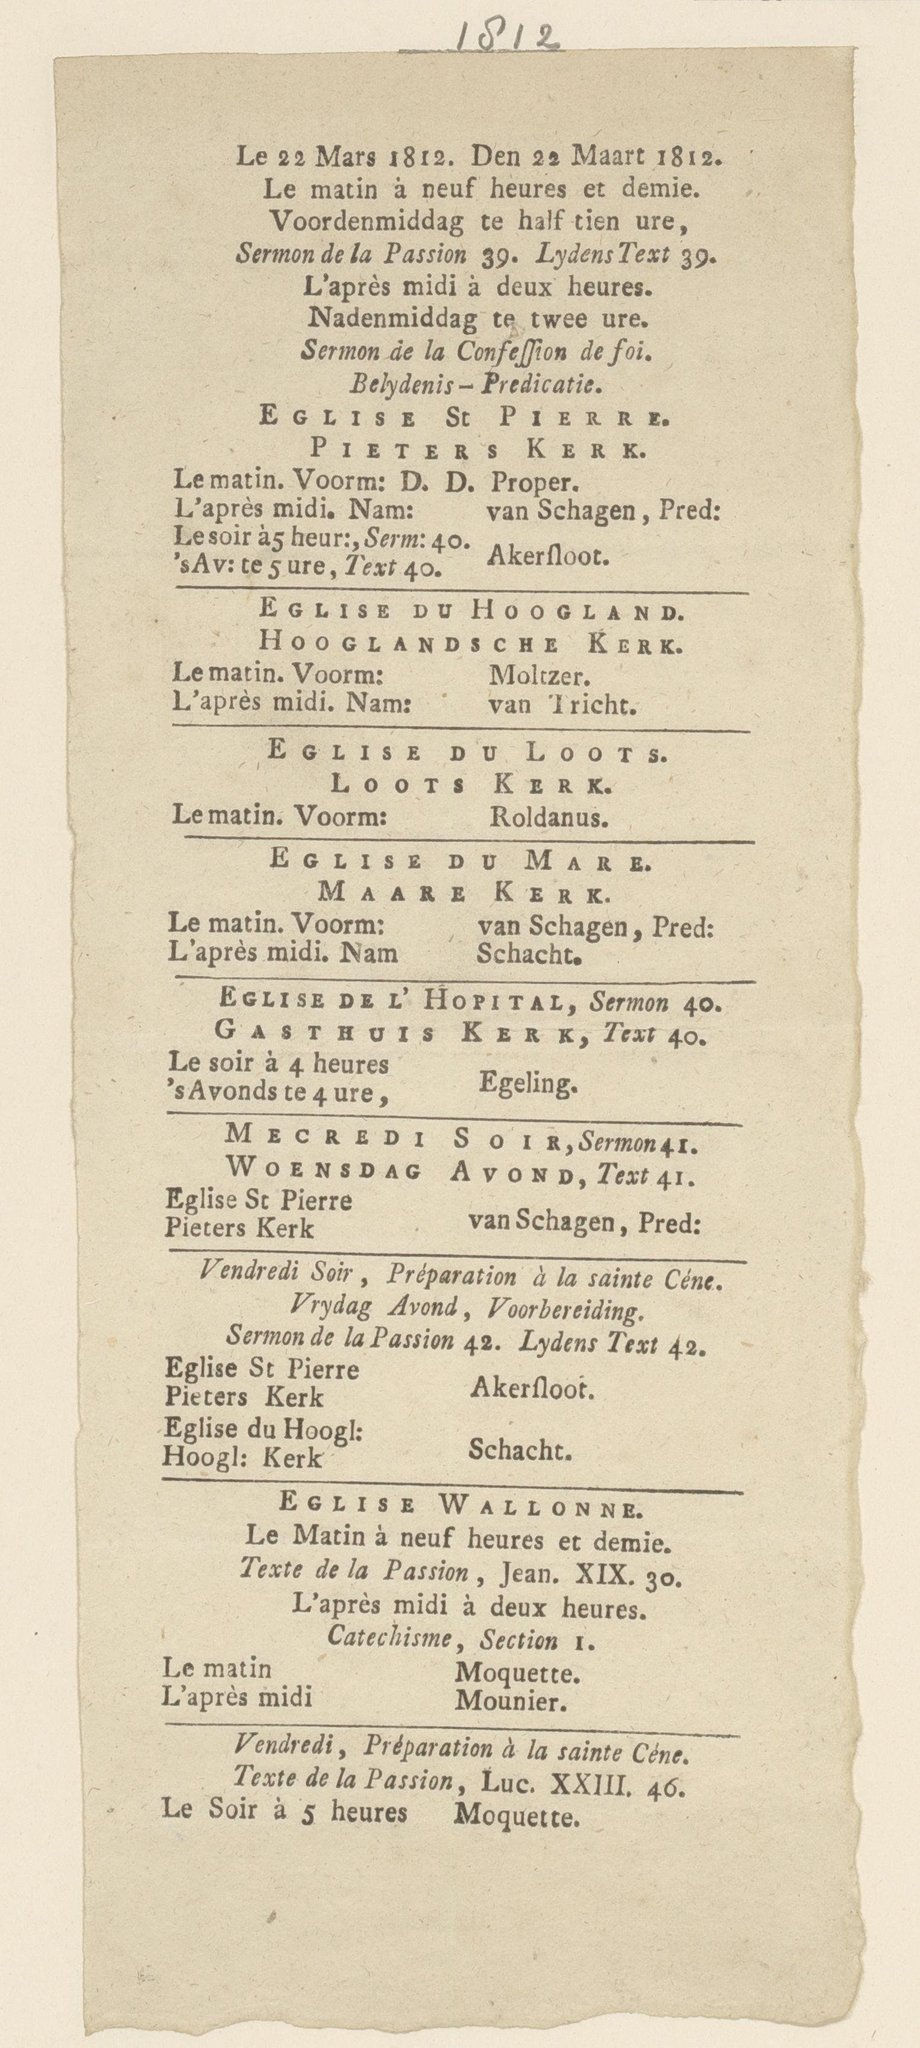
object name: text sheet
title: Preken in Leiden in de week van 22 maart 1812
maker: Anonymous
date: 1812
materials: paper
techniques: letterpress printing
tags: preaching (in general), leiden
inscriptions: collector's mark: Lugt 1641, stamp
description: Preken in Leiden in de week van 22 maart 1812, met de namen van de predikanten. Onderwerpsrubrieken binnen de Atlas Zeden en Gewoonten: Godsdienst, Predikbeurtenlijstjes.